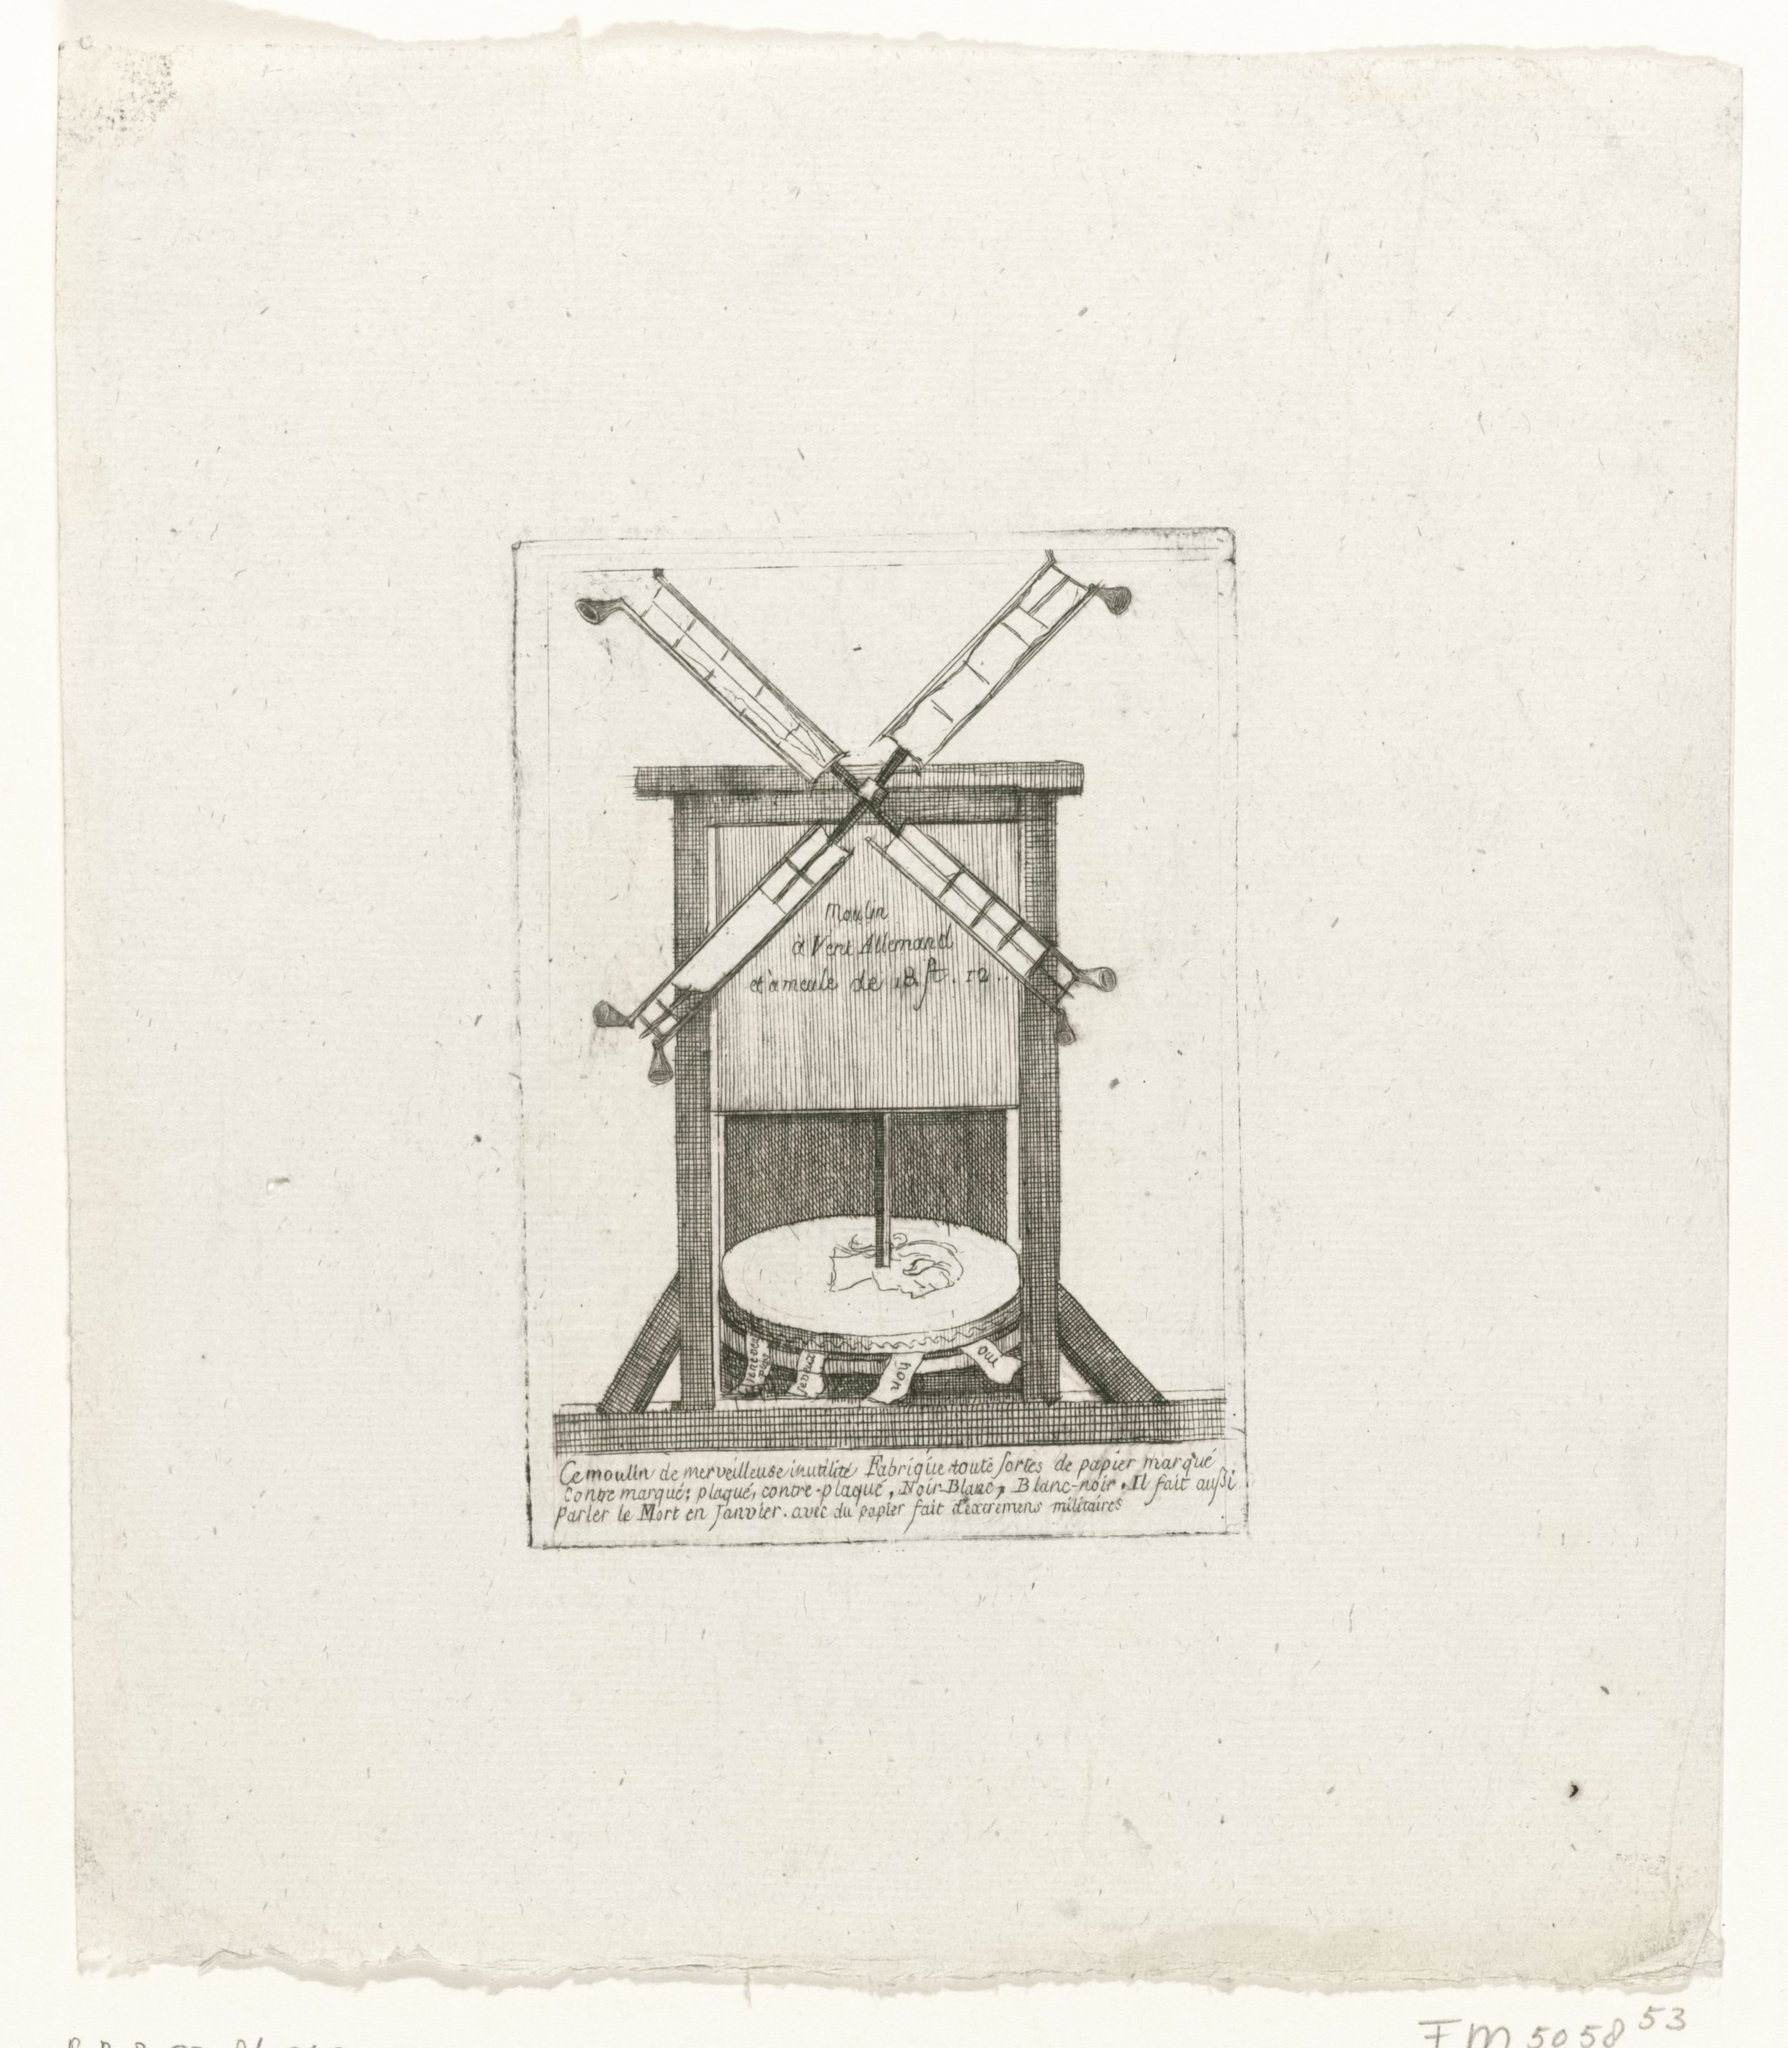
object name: cartoon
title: Duitse windmolen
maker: Anonymous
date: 1787-1790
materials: paper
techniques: engraving, etching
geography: southern netherlands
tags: vienna, jozef ii (duits keizer), windmill, brabant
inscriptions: collector's mark: Lugt 2228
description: Spotprent met een Duitse windmolen waarin allerlei soorten papier gemaakt worden. Op de molensteen de kop van Jozef II. Met Frans onderschrift van drie regels. Onderdeel van een grote groep van prenten betrekking hebbend op de gebeurtenissen van de Brabantse Omwenteling en de periode 1787-1790.